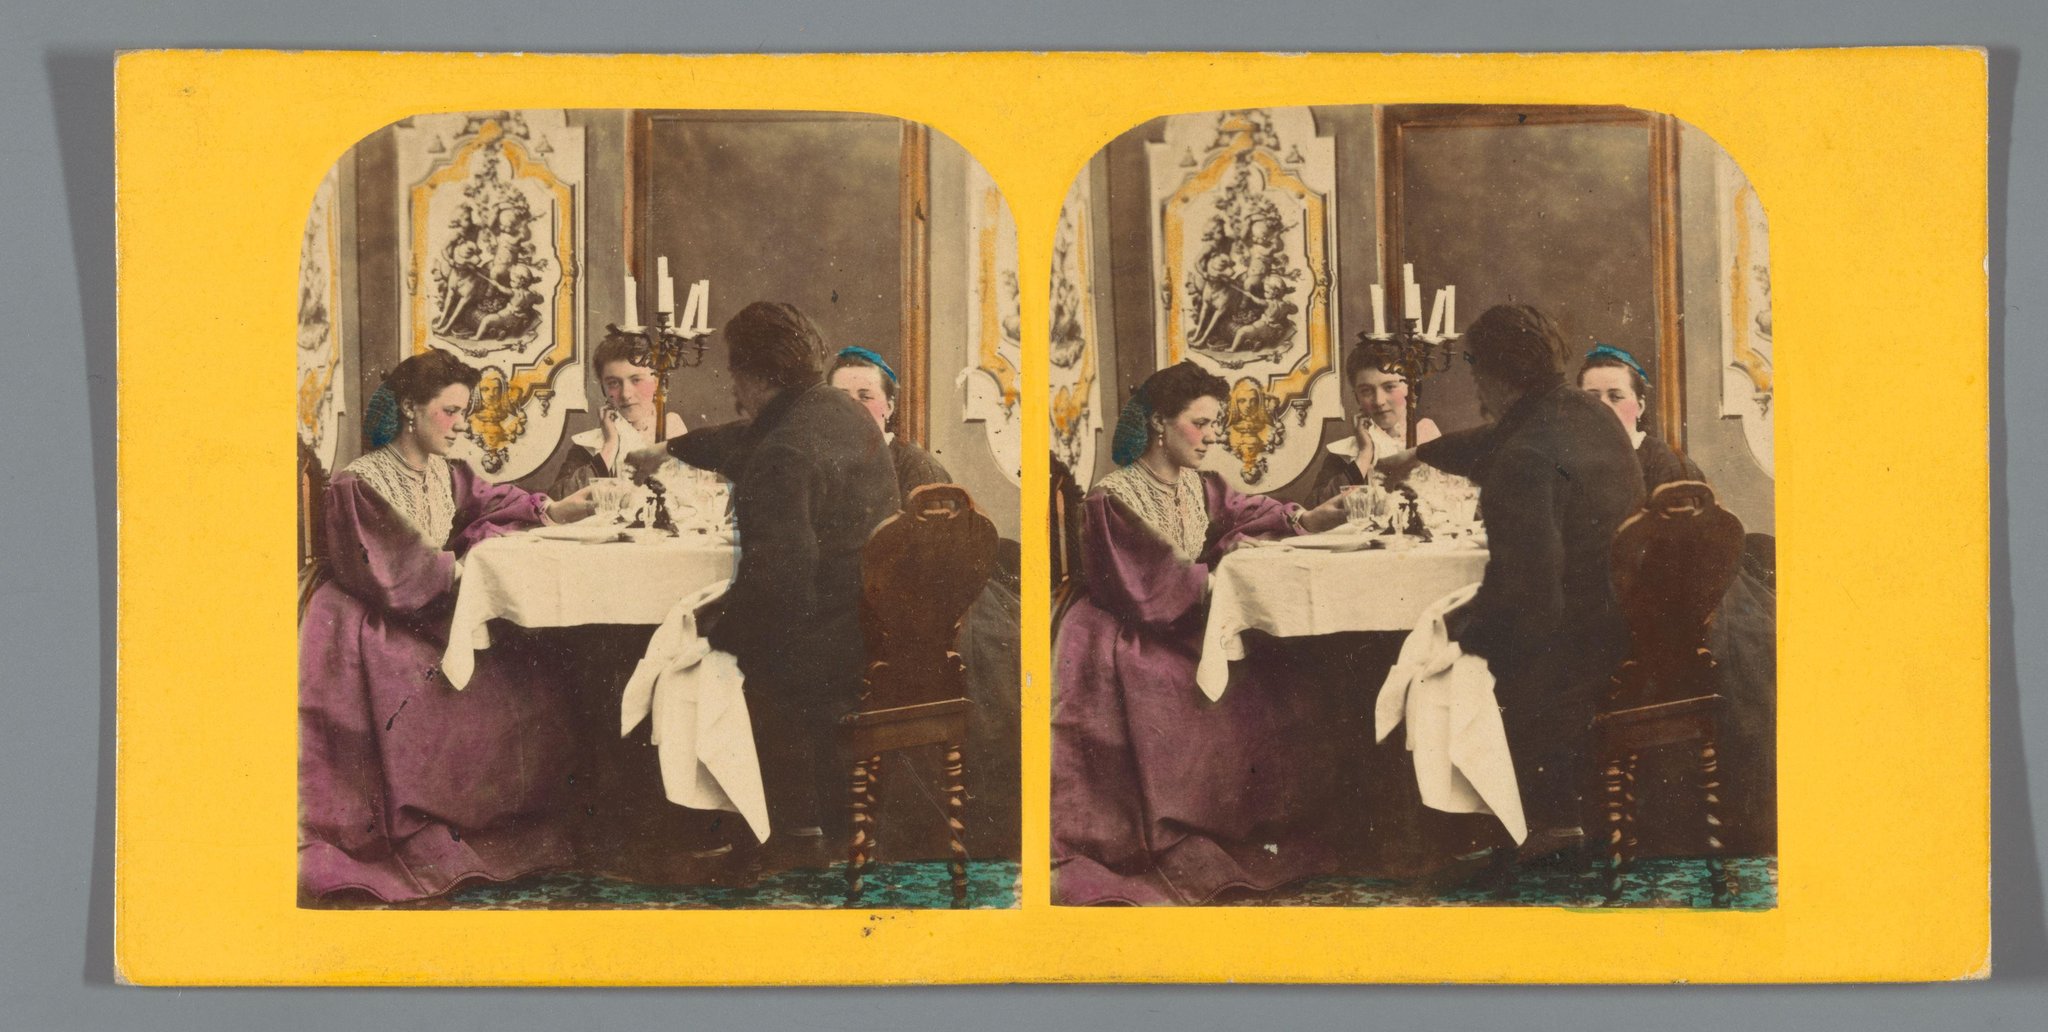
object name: stereograph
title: Gezelschap rondom een tafel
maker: Anonymous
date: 1858-1870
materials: cardboard, paper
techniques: albumen print, hand coloring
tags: evening meal, dinner, supper, dining-room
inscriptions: inscription: ‘B’